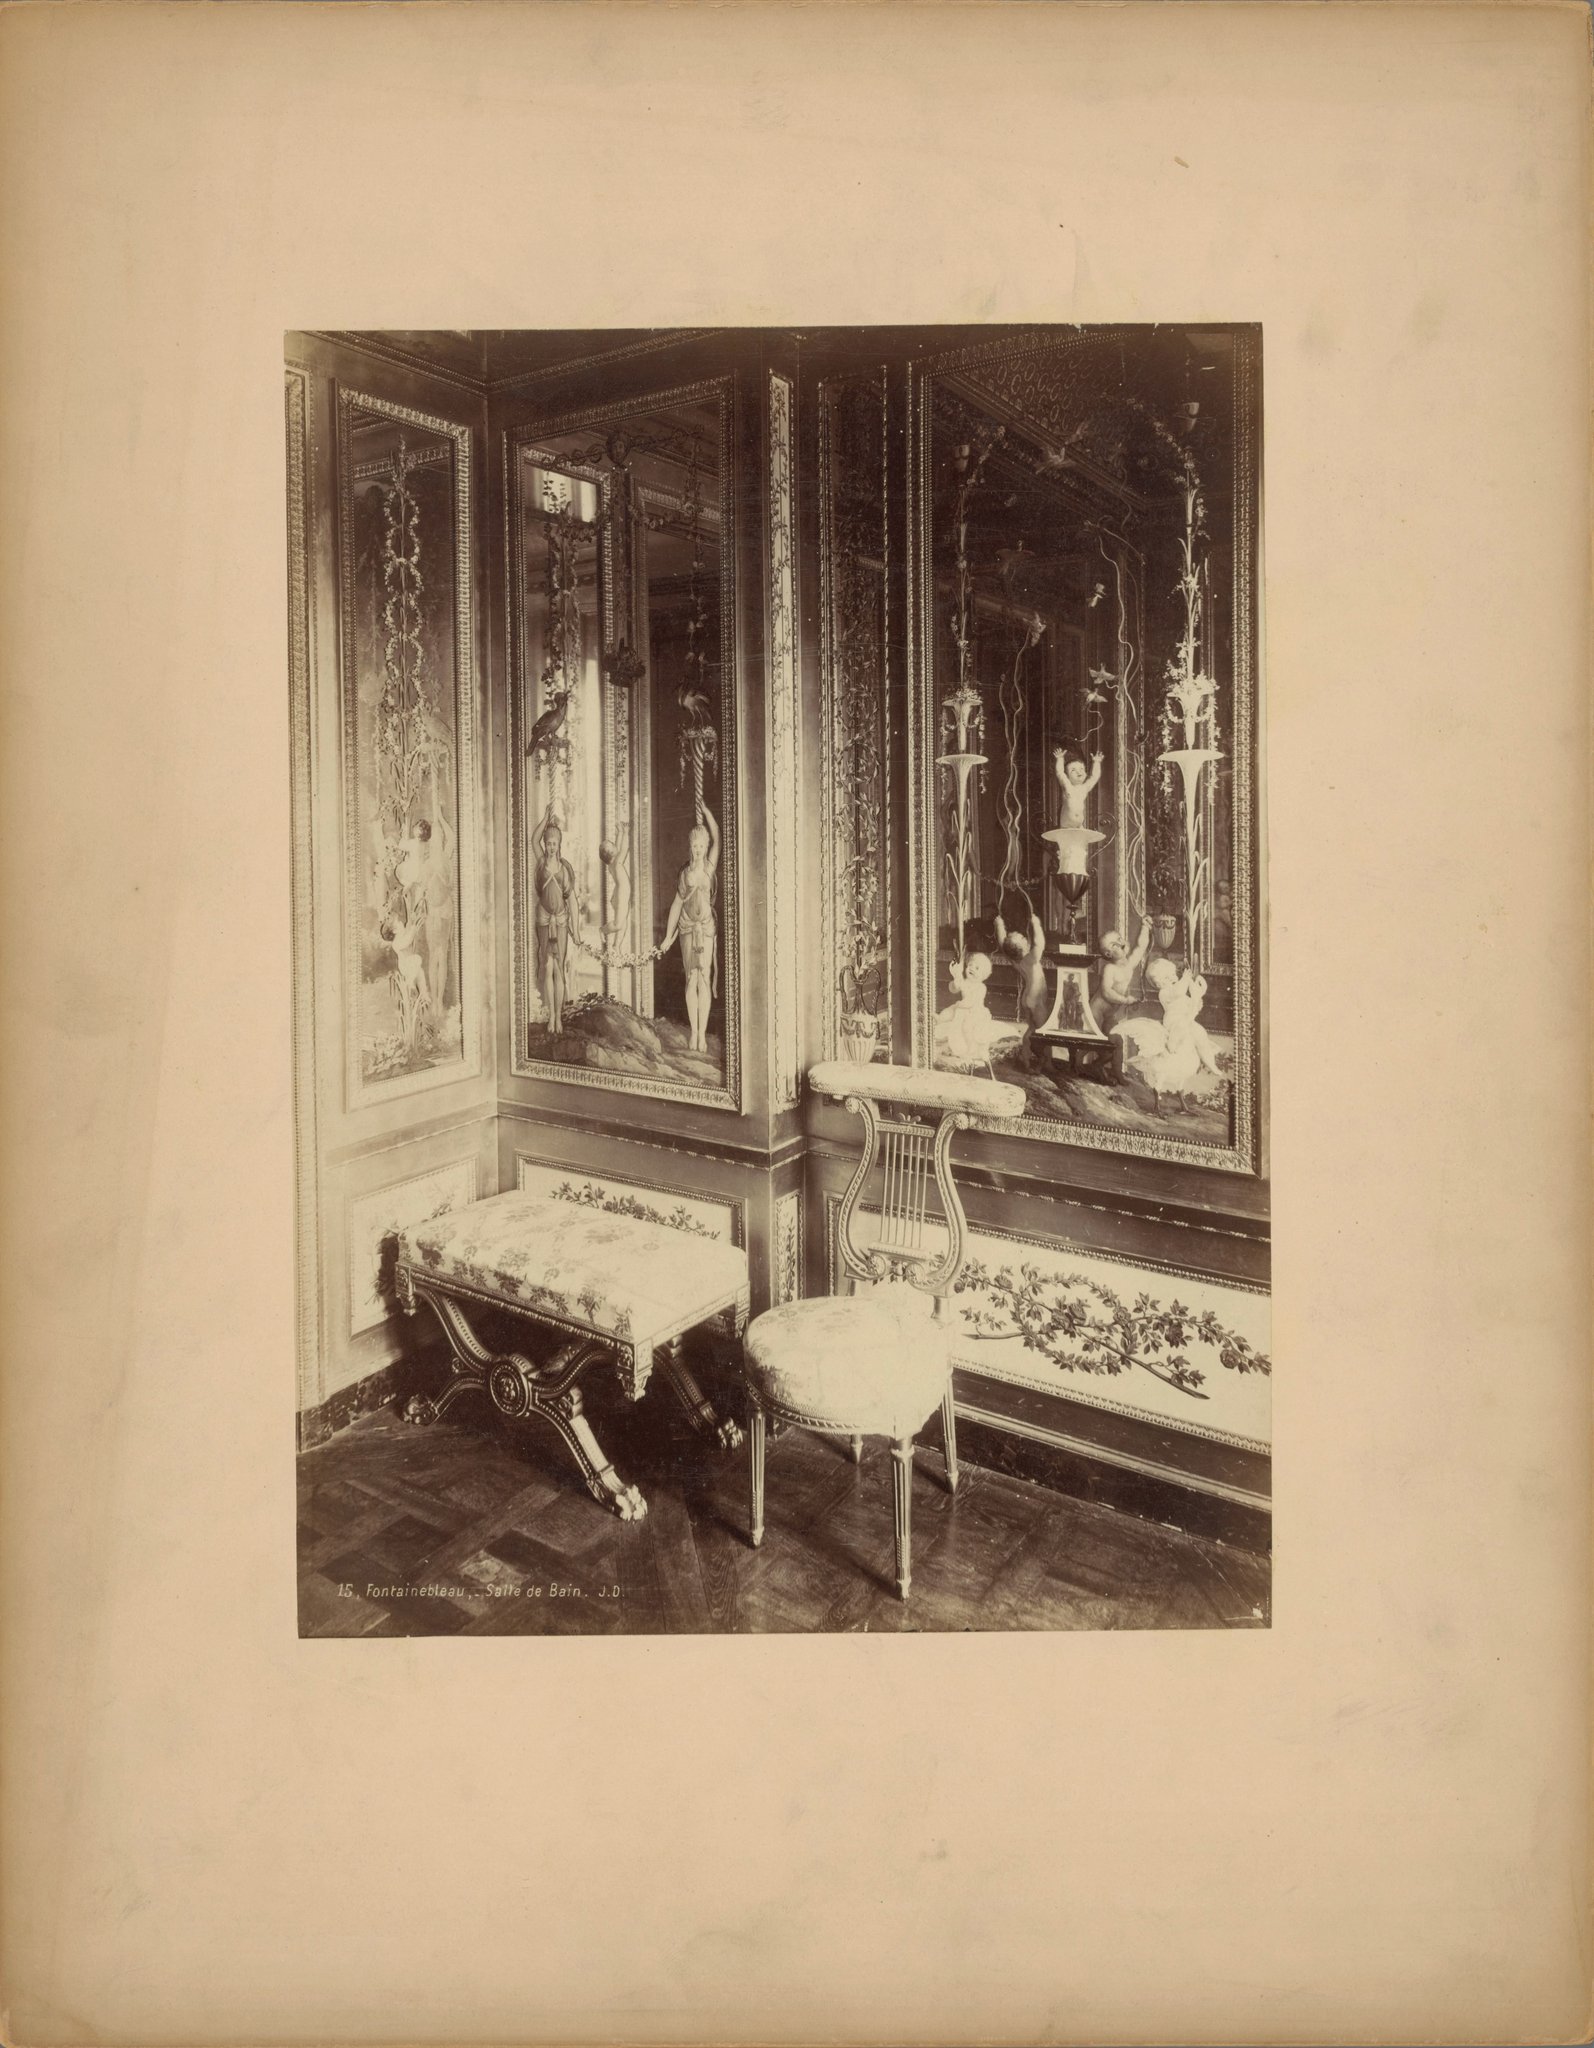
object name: photograph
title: Versailles - Cabinet de travails.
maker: jd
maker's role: fotograaf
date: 1875-1900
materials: cardboard, photographic support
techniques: albumen print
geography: versailles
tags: mirror, chandelier, candelabrum, palace, interior of the house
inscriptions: collector's mark: Lugt 3937, number: ‘42’